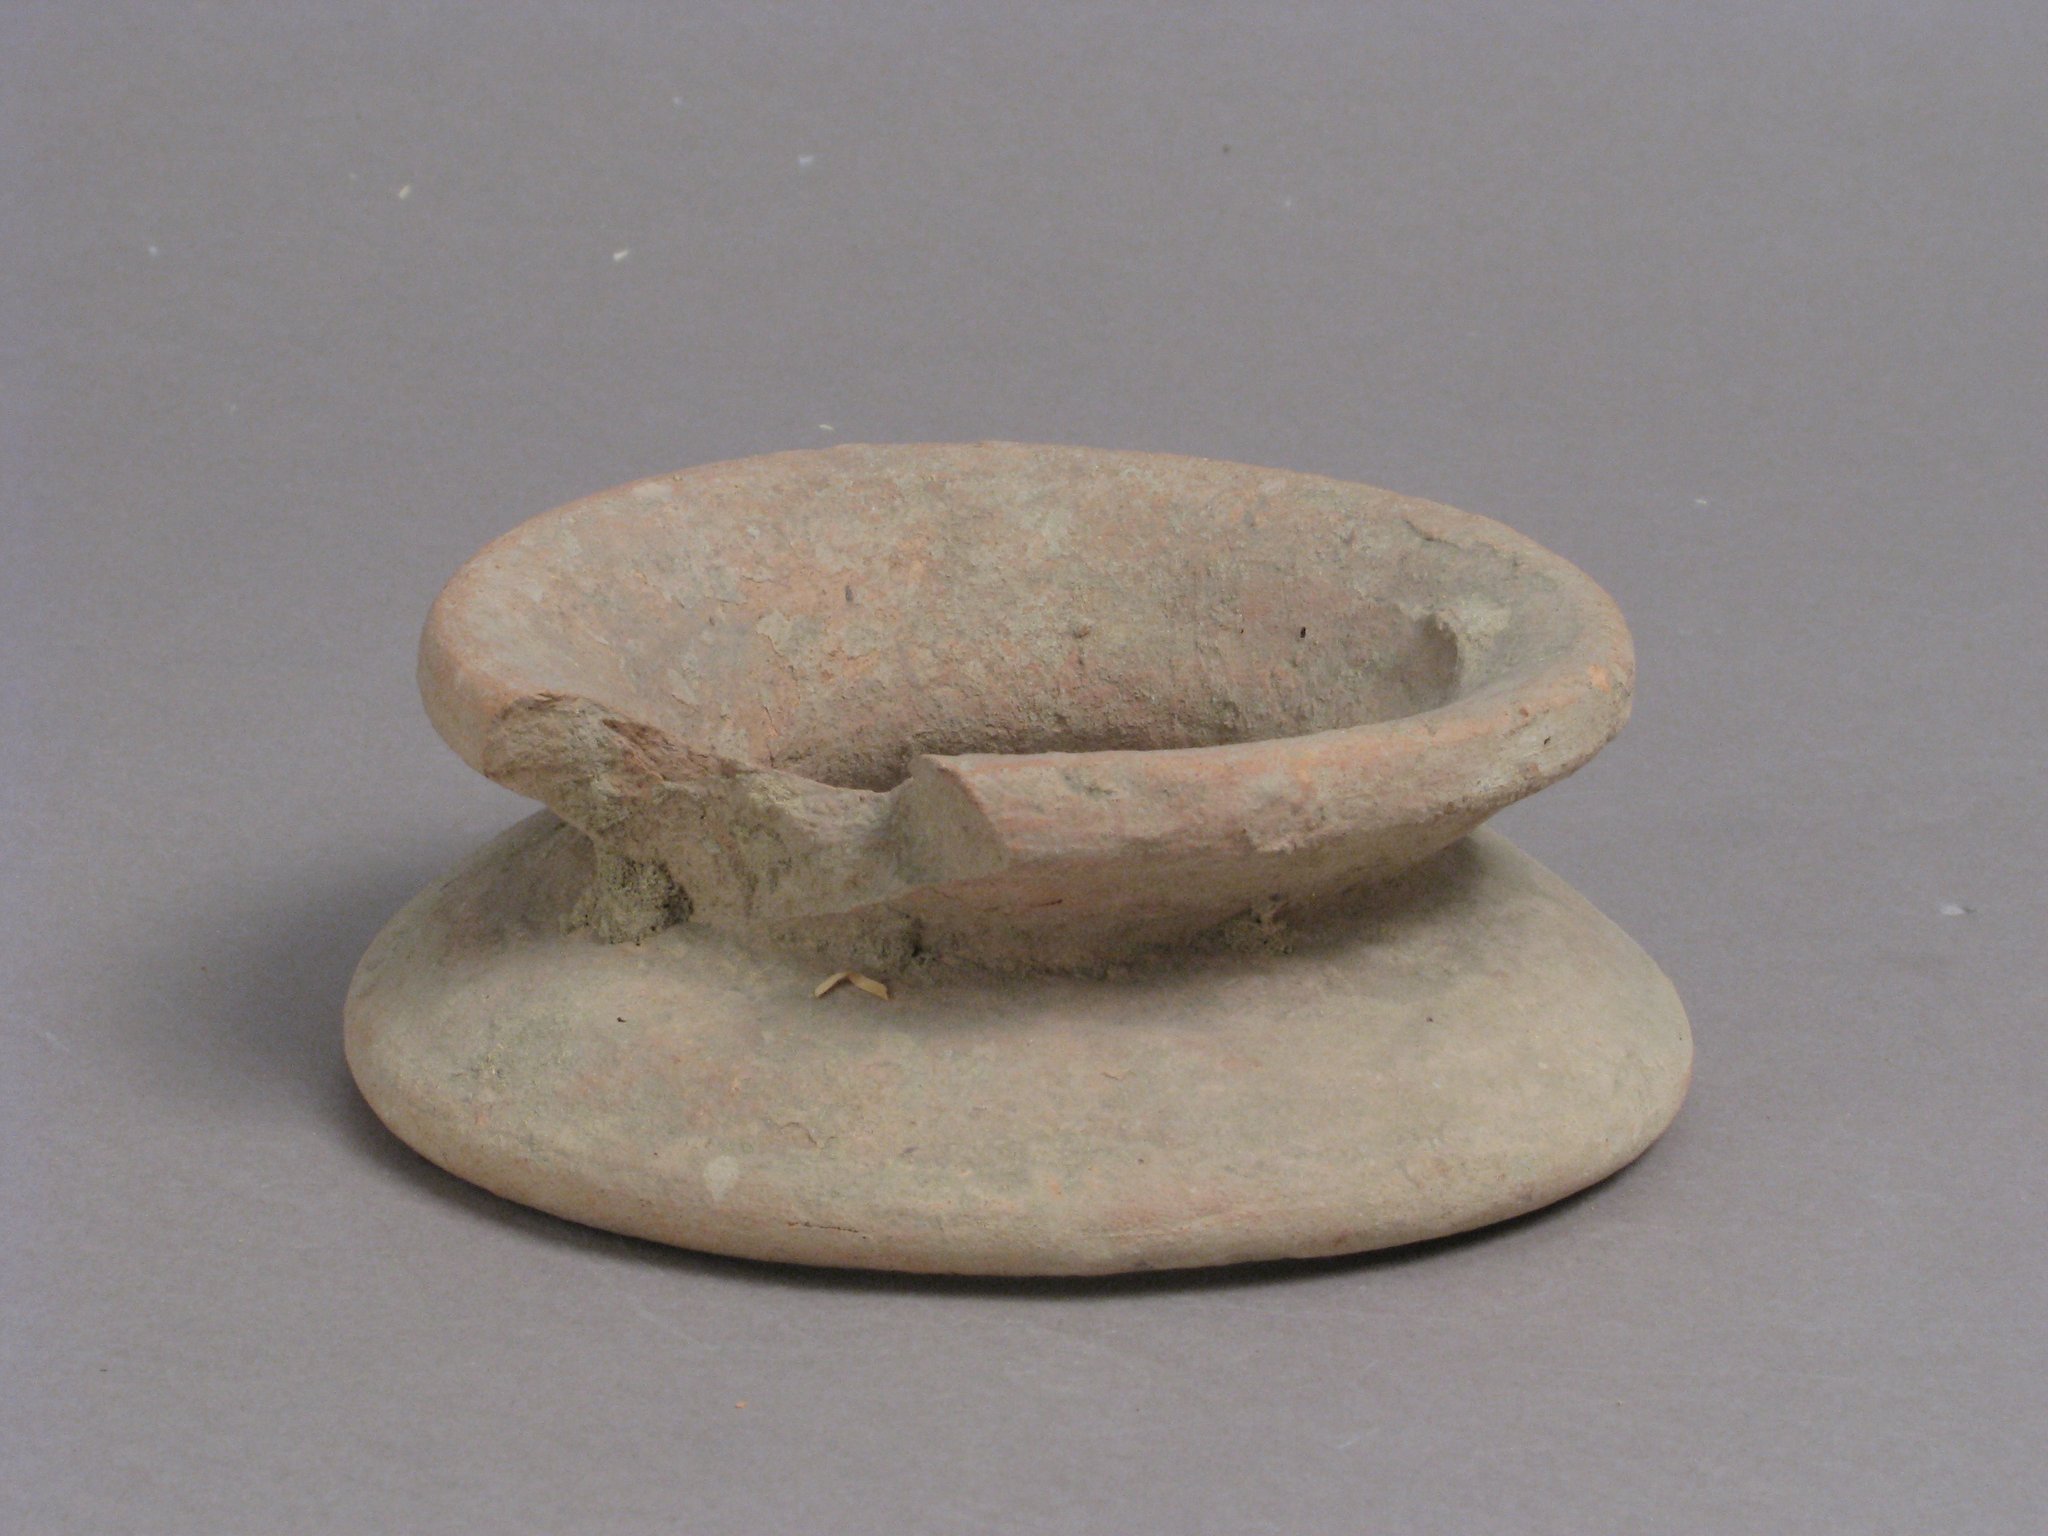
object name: ring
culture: coptic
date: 301-700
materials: earthenware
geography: egypt